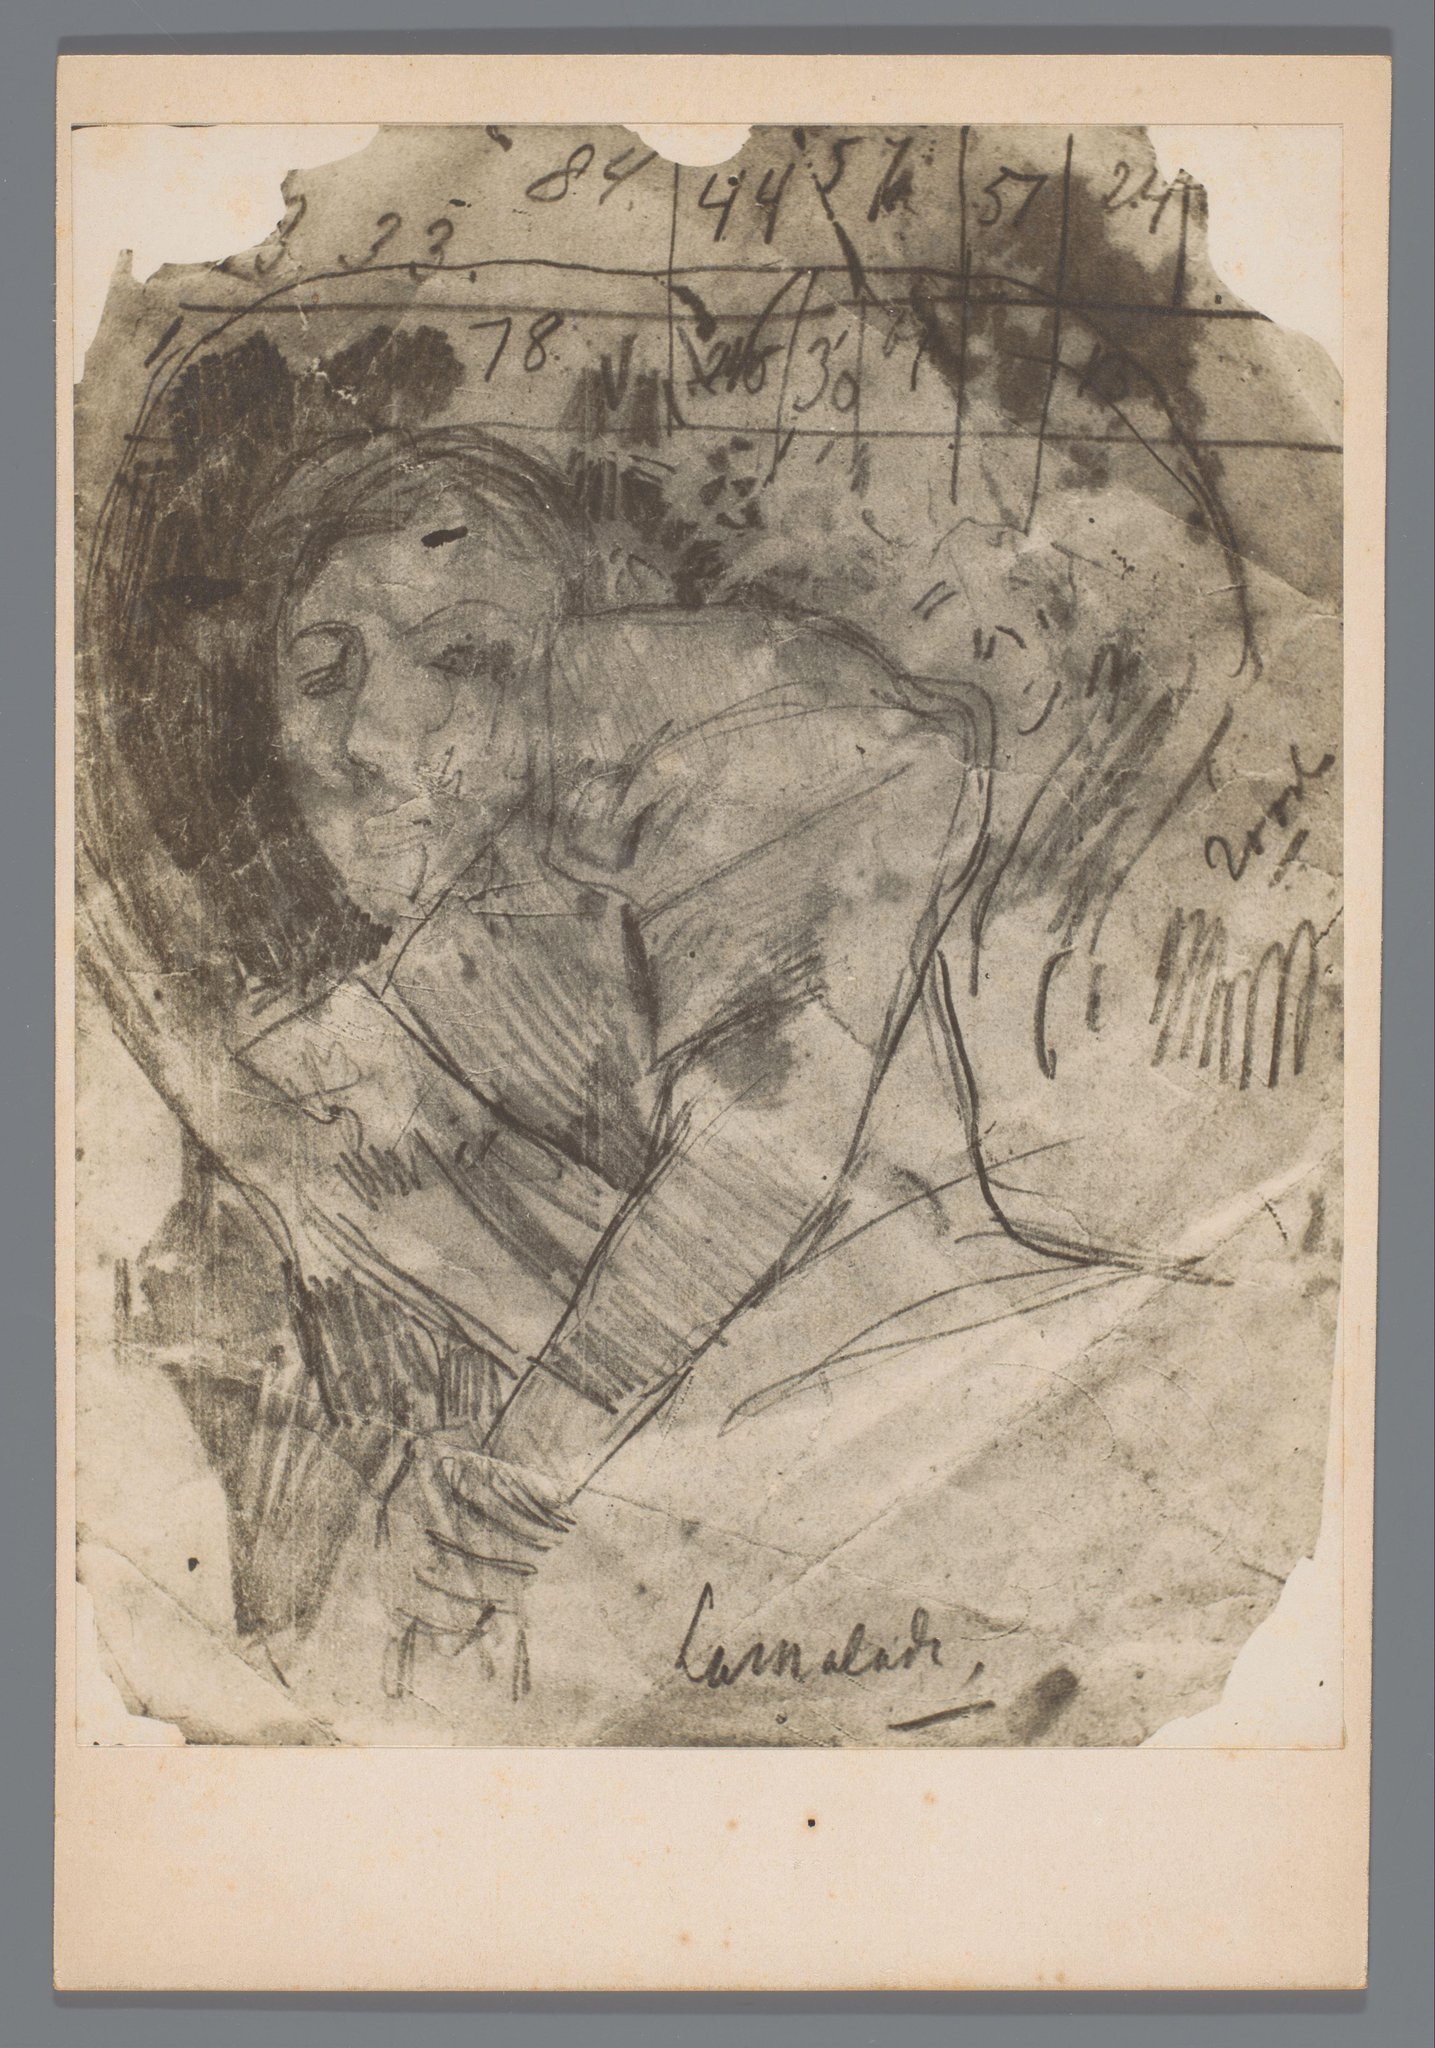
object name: reproduction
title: Fotoreproductie van een voorstudie voor een portret van Marie Breitner-Jordan naar George Hendrik Breitner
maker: Anonymous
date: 1890-1910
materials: paper, cardboard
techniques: gelatin silver print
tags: marie jordan, drawing, sketch